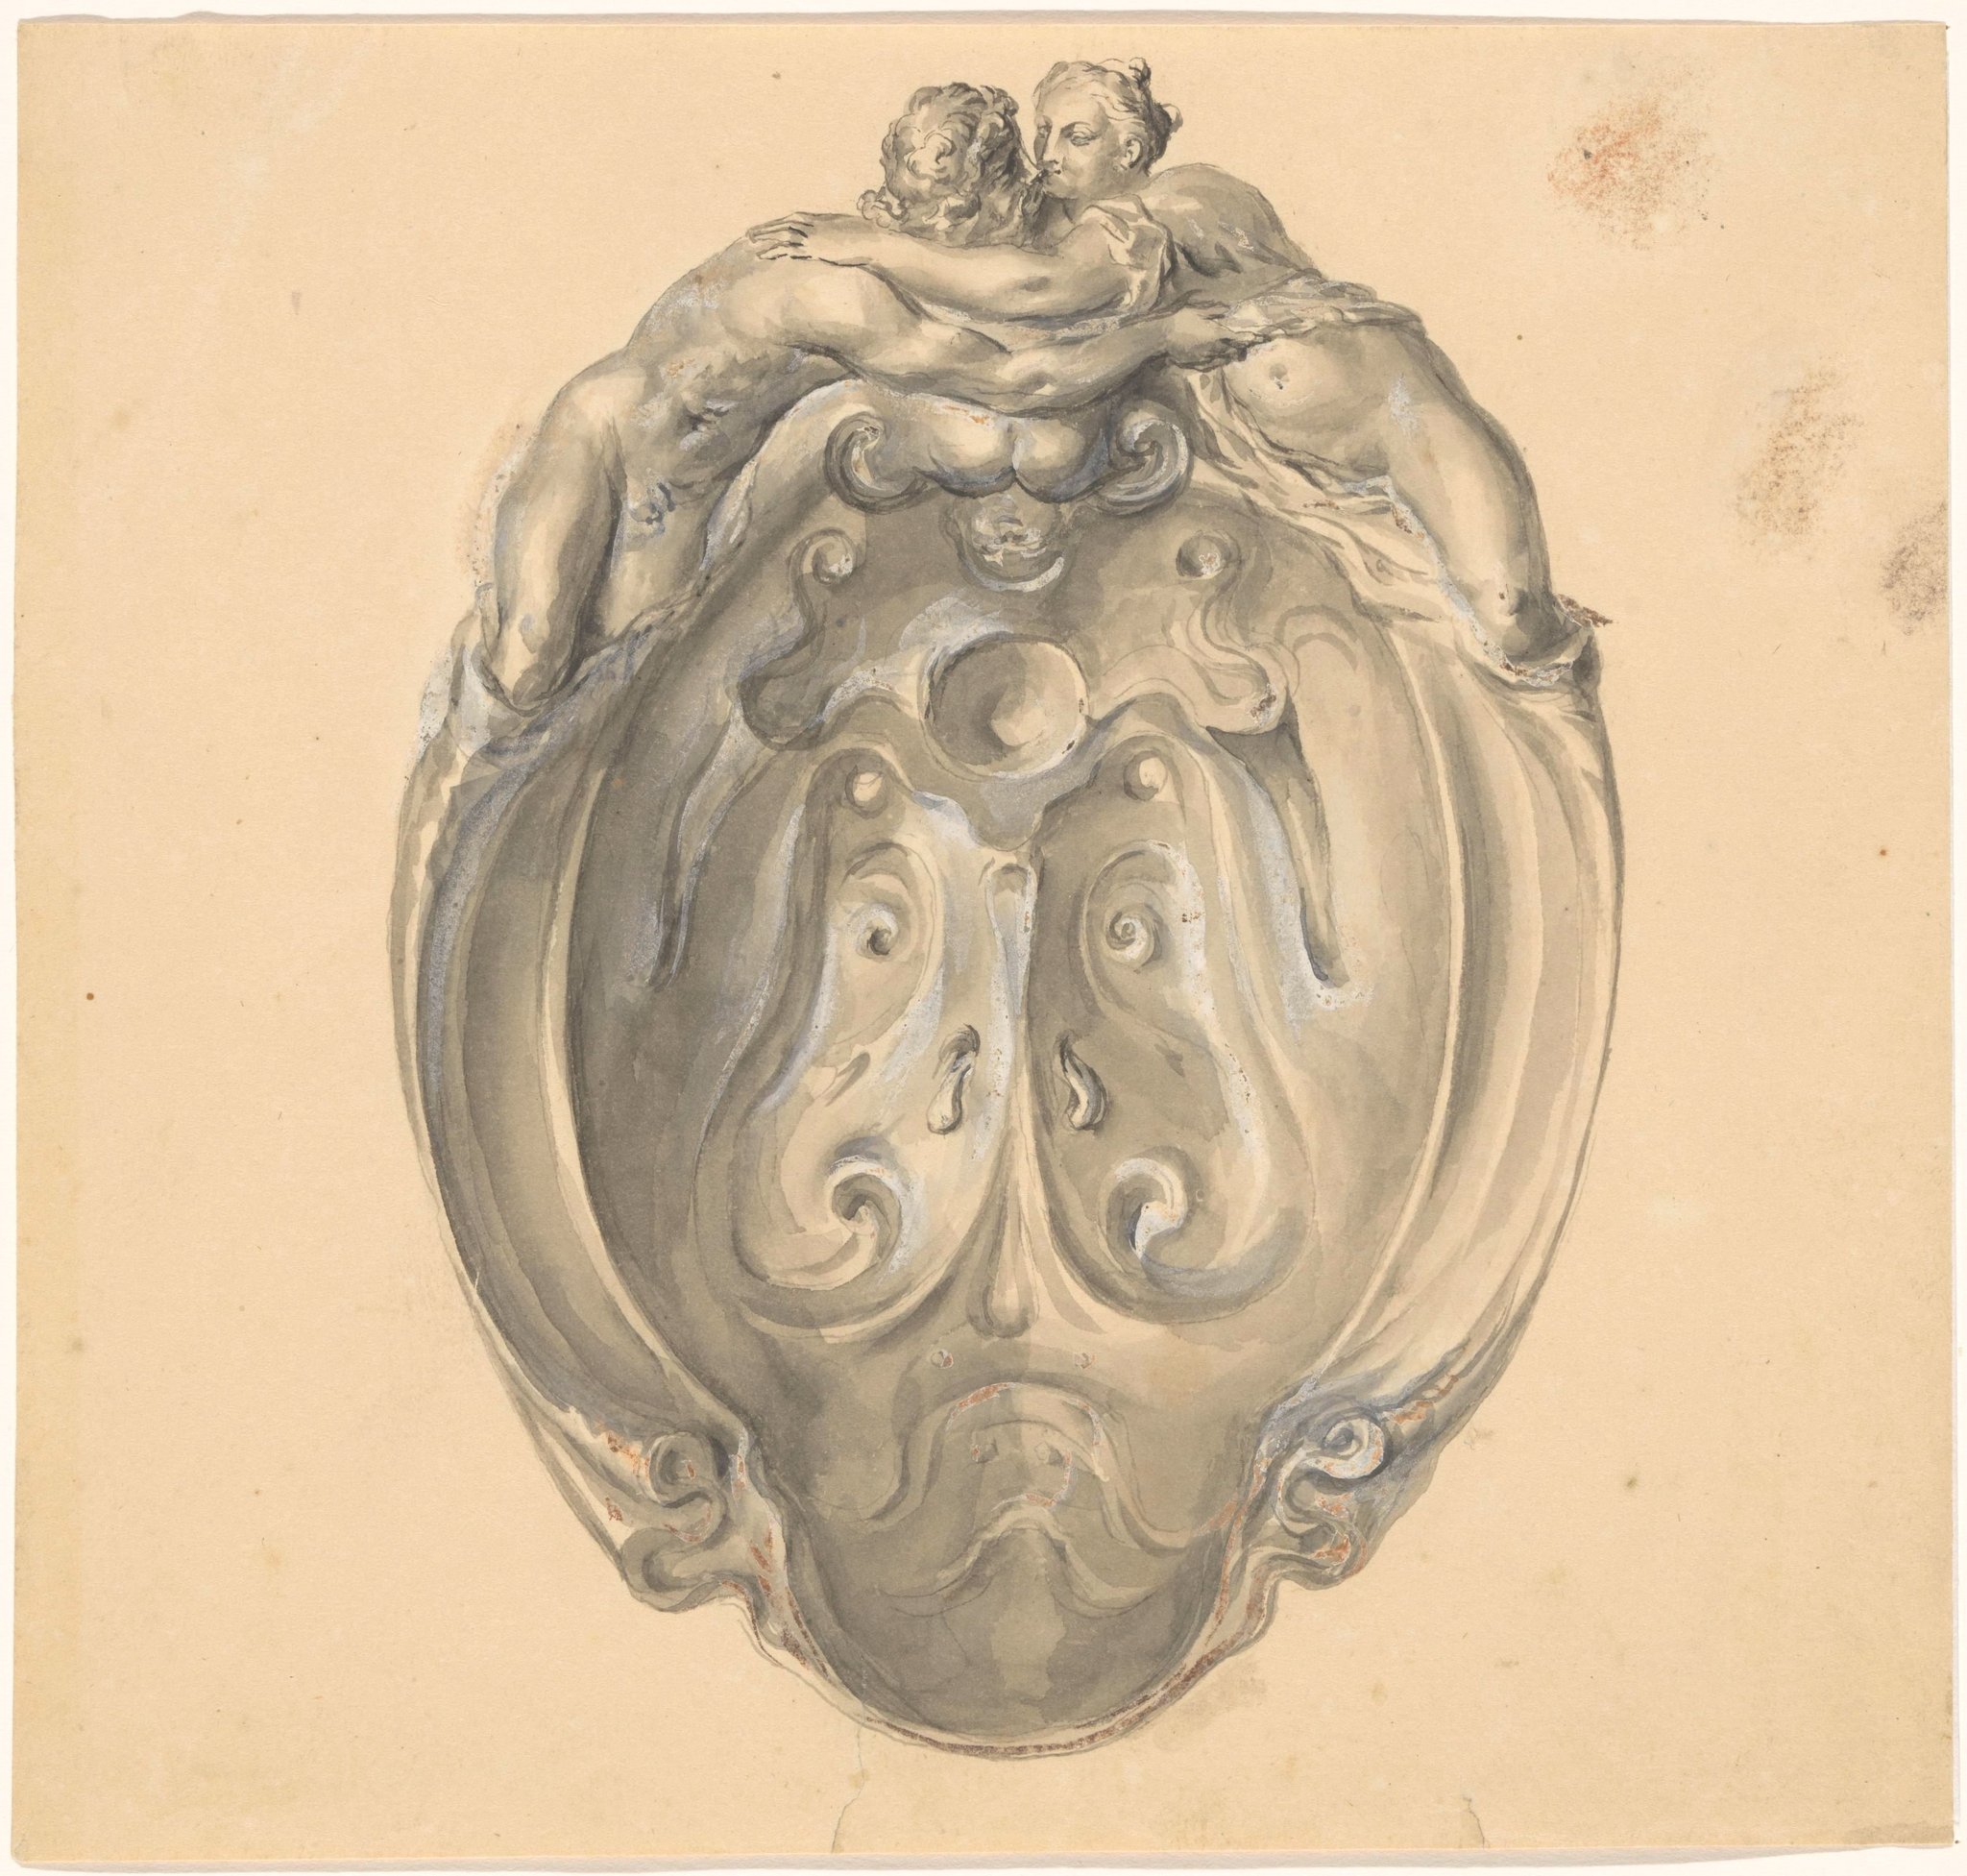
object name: album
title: Tekening van 17e eeuws zilver behorende bij een album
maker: Anonymous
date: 1725-1728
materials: paper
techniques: drawing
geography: amsterdam